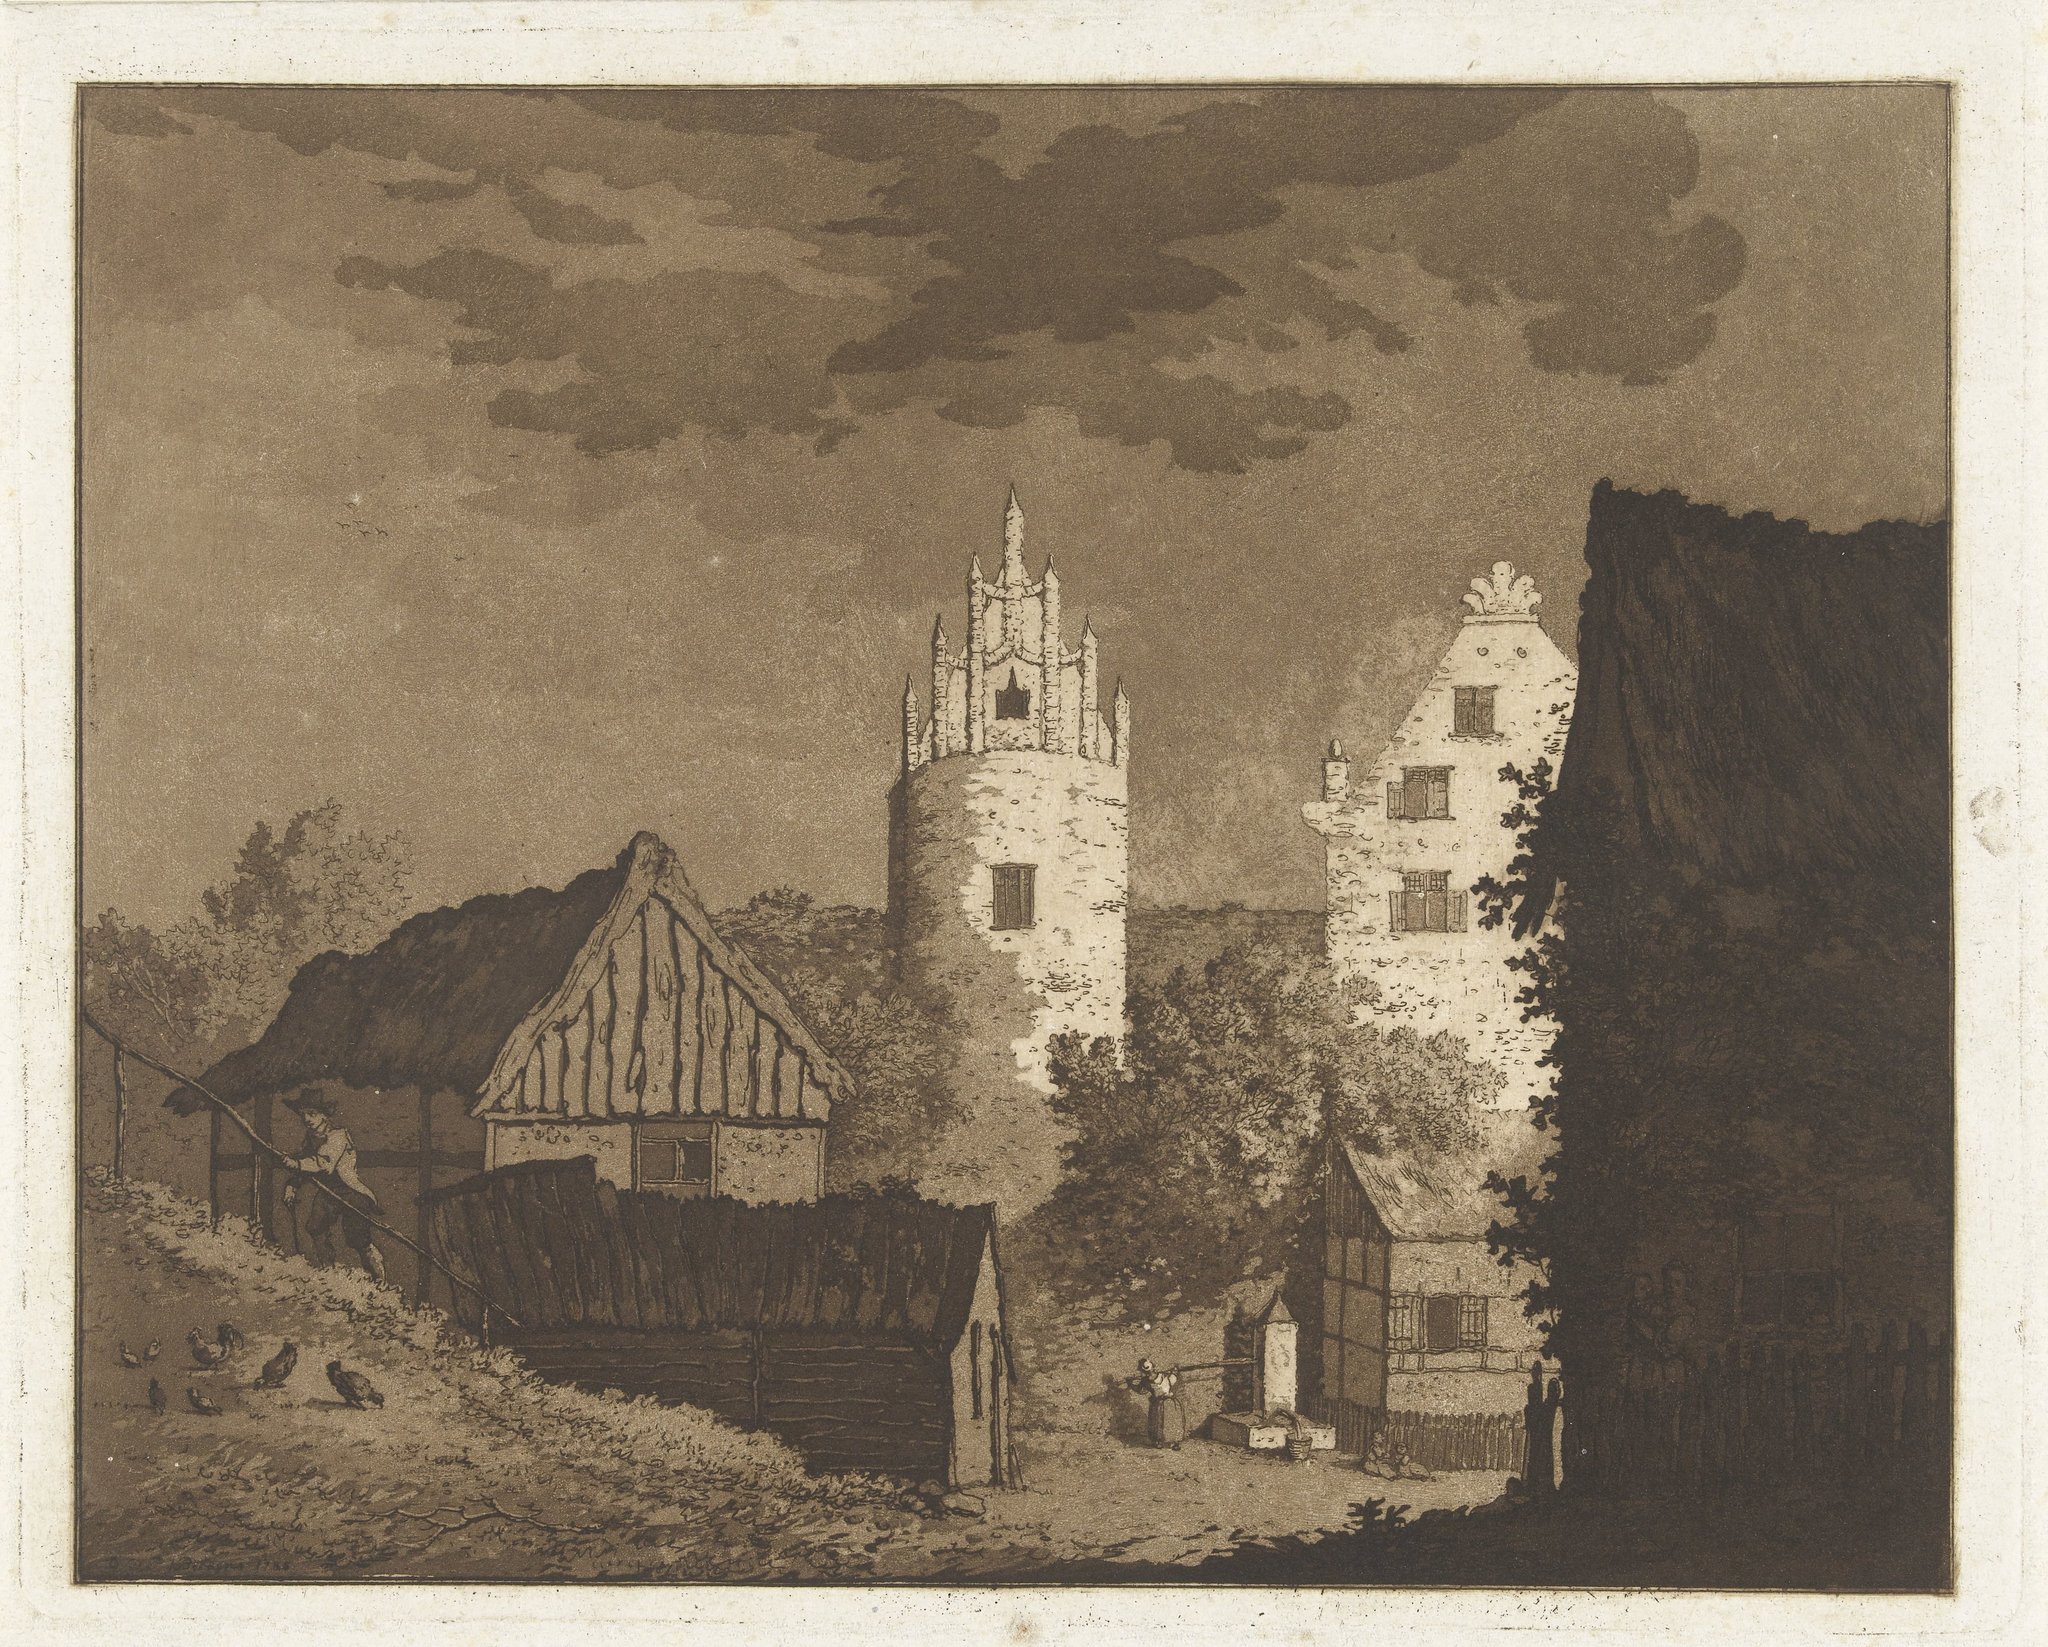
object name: print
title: Dorpsgezicht met vrouw bij pomp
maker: daniël dupré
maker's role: draughtsman, print maker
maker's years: 1751-1817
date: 1786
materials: paper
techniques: aquatint, etching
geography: bologna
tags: village street, pump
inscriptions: collector's mark: Lugt 2228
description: Italiaans dorpsgezicht met ronde toren en woonhuizen. Een vrouw staat bij een pomp water te tappen. Op de voorgrond loopt een man via een trap de stadswal op.